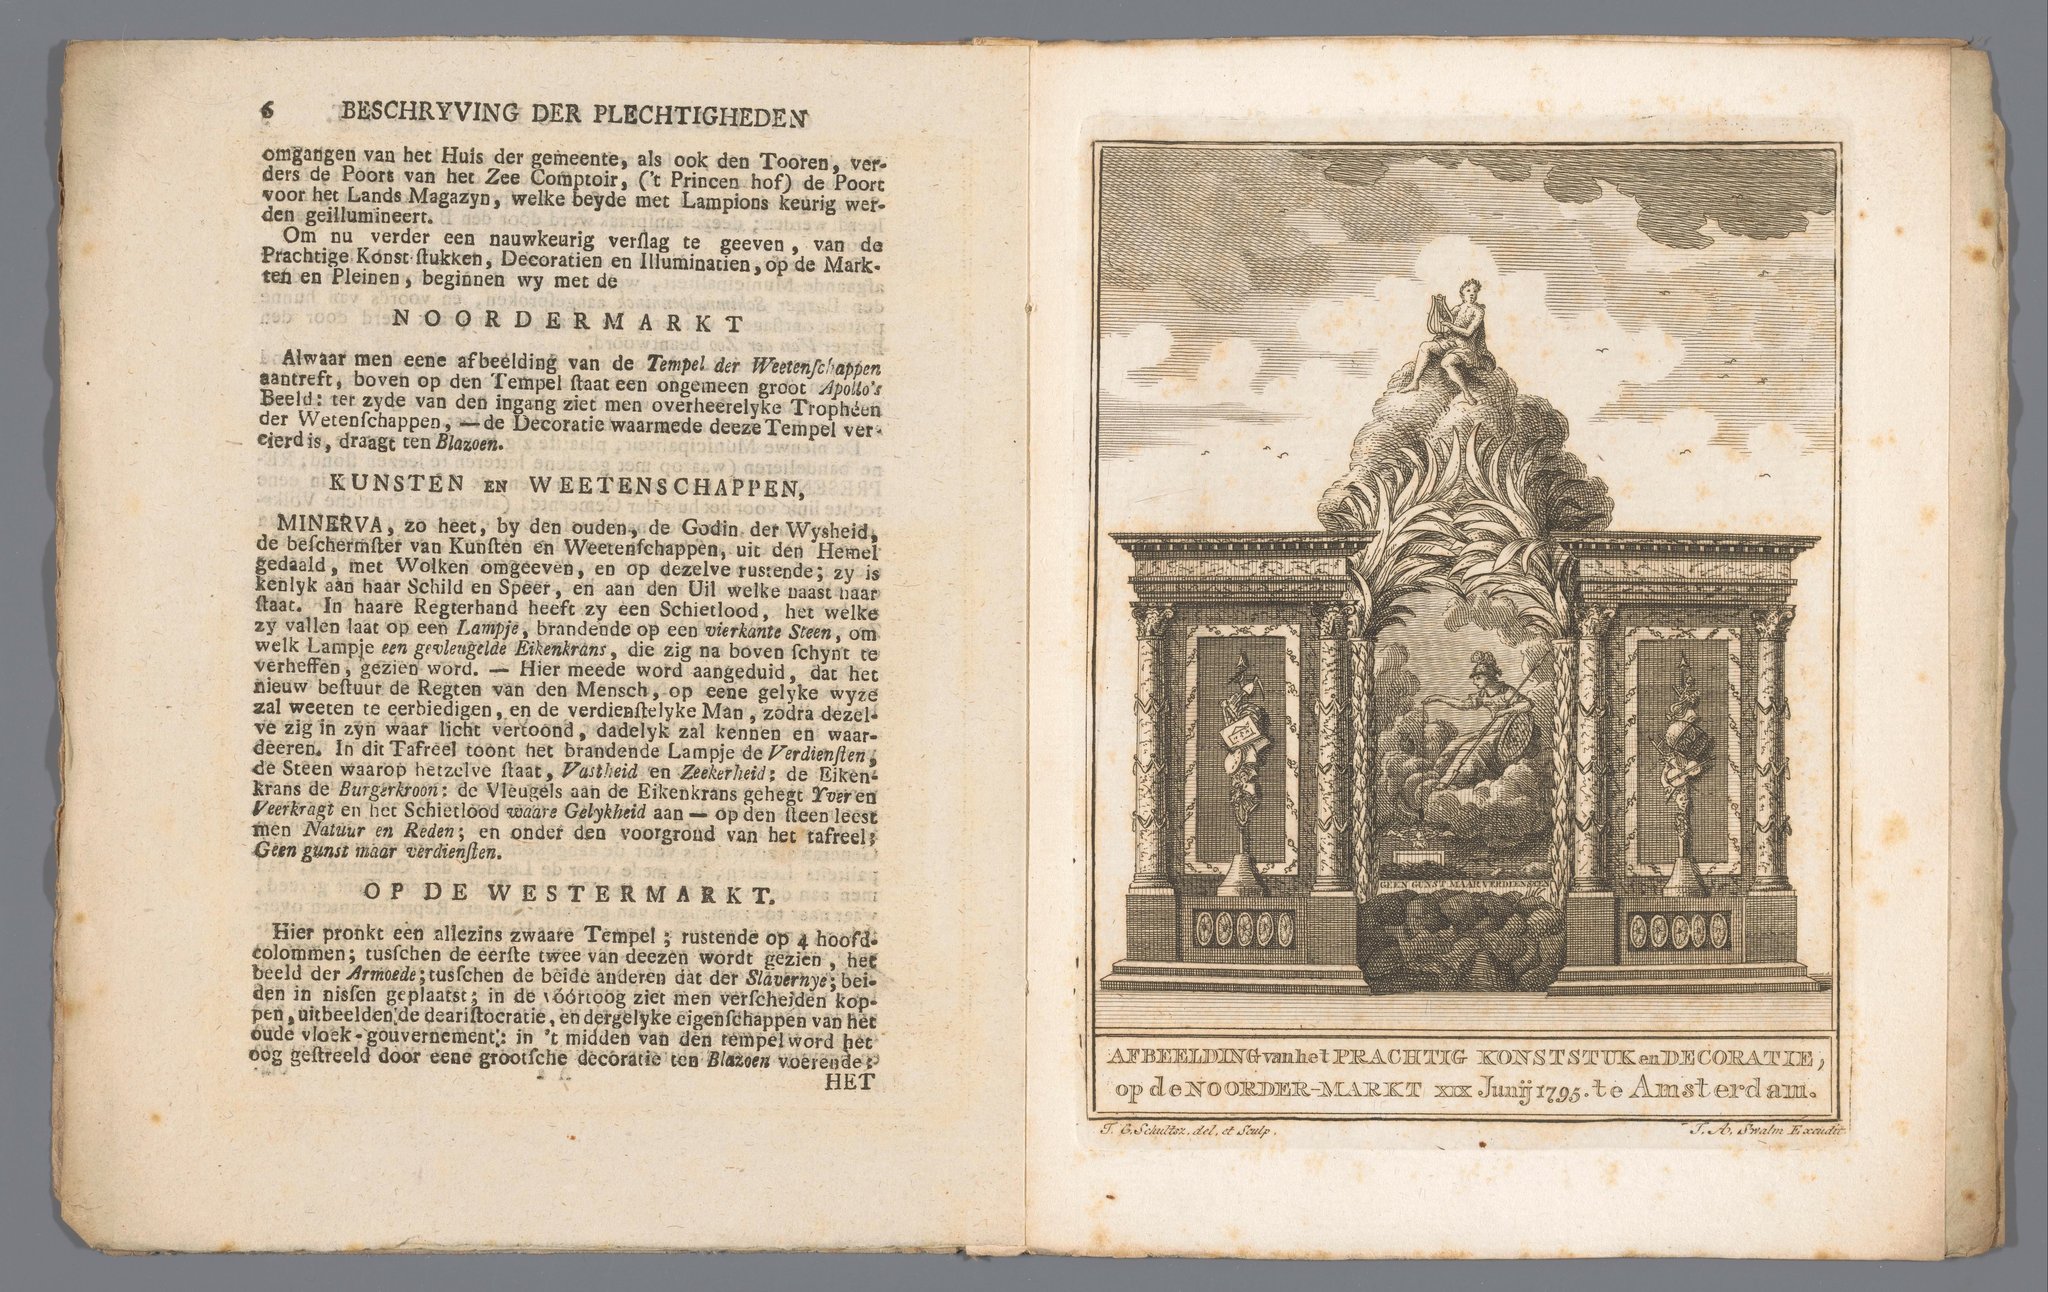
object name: book illustration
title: Afbeelding van het Prachtig Konststuk en Decoratie, op de Noorder-Markt XIX Junij 1795. te Amsterdam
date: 1795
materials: paper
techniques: engraving, etching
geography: netherlands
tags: specific aspects, allegorical aspects of minerva; minerva as patroness, festivities on events of national importance (+ festive decoration ~ festive activities), equality, equity, fairness, righteousness; 'equalità', 'equità', 'giuditio giusto', 'ordine dritto e giusto', 'ugualità' (ripa) (+ symbolical representation of concept), alliance with france (1795)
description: Kunsten en Wetenschappen, allegorische decoratie opgericht op de Noordermarkt te Amsterdam bij het Alliantiefeest op 19 juni 1795. Minerva zittend in de wolken met schietlood (Gelijkheid) boven een krans en vuur. Bovenaan Apollo spelend op de lier.